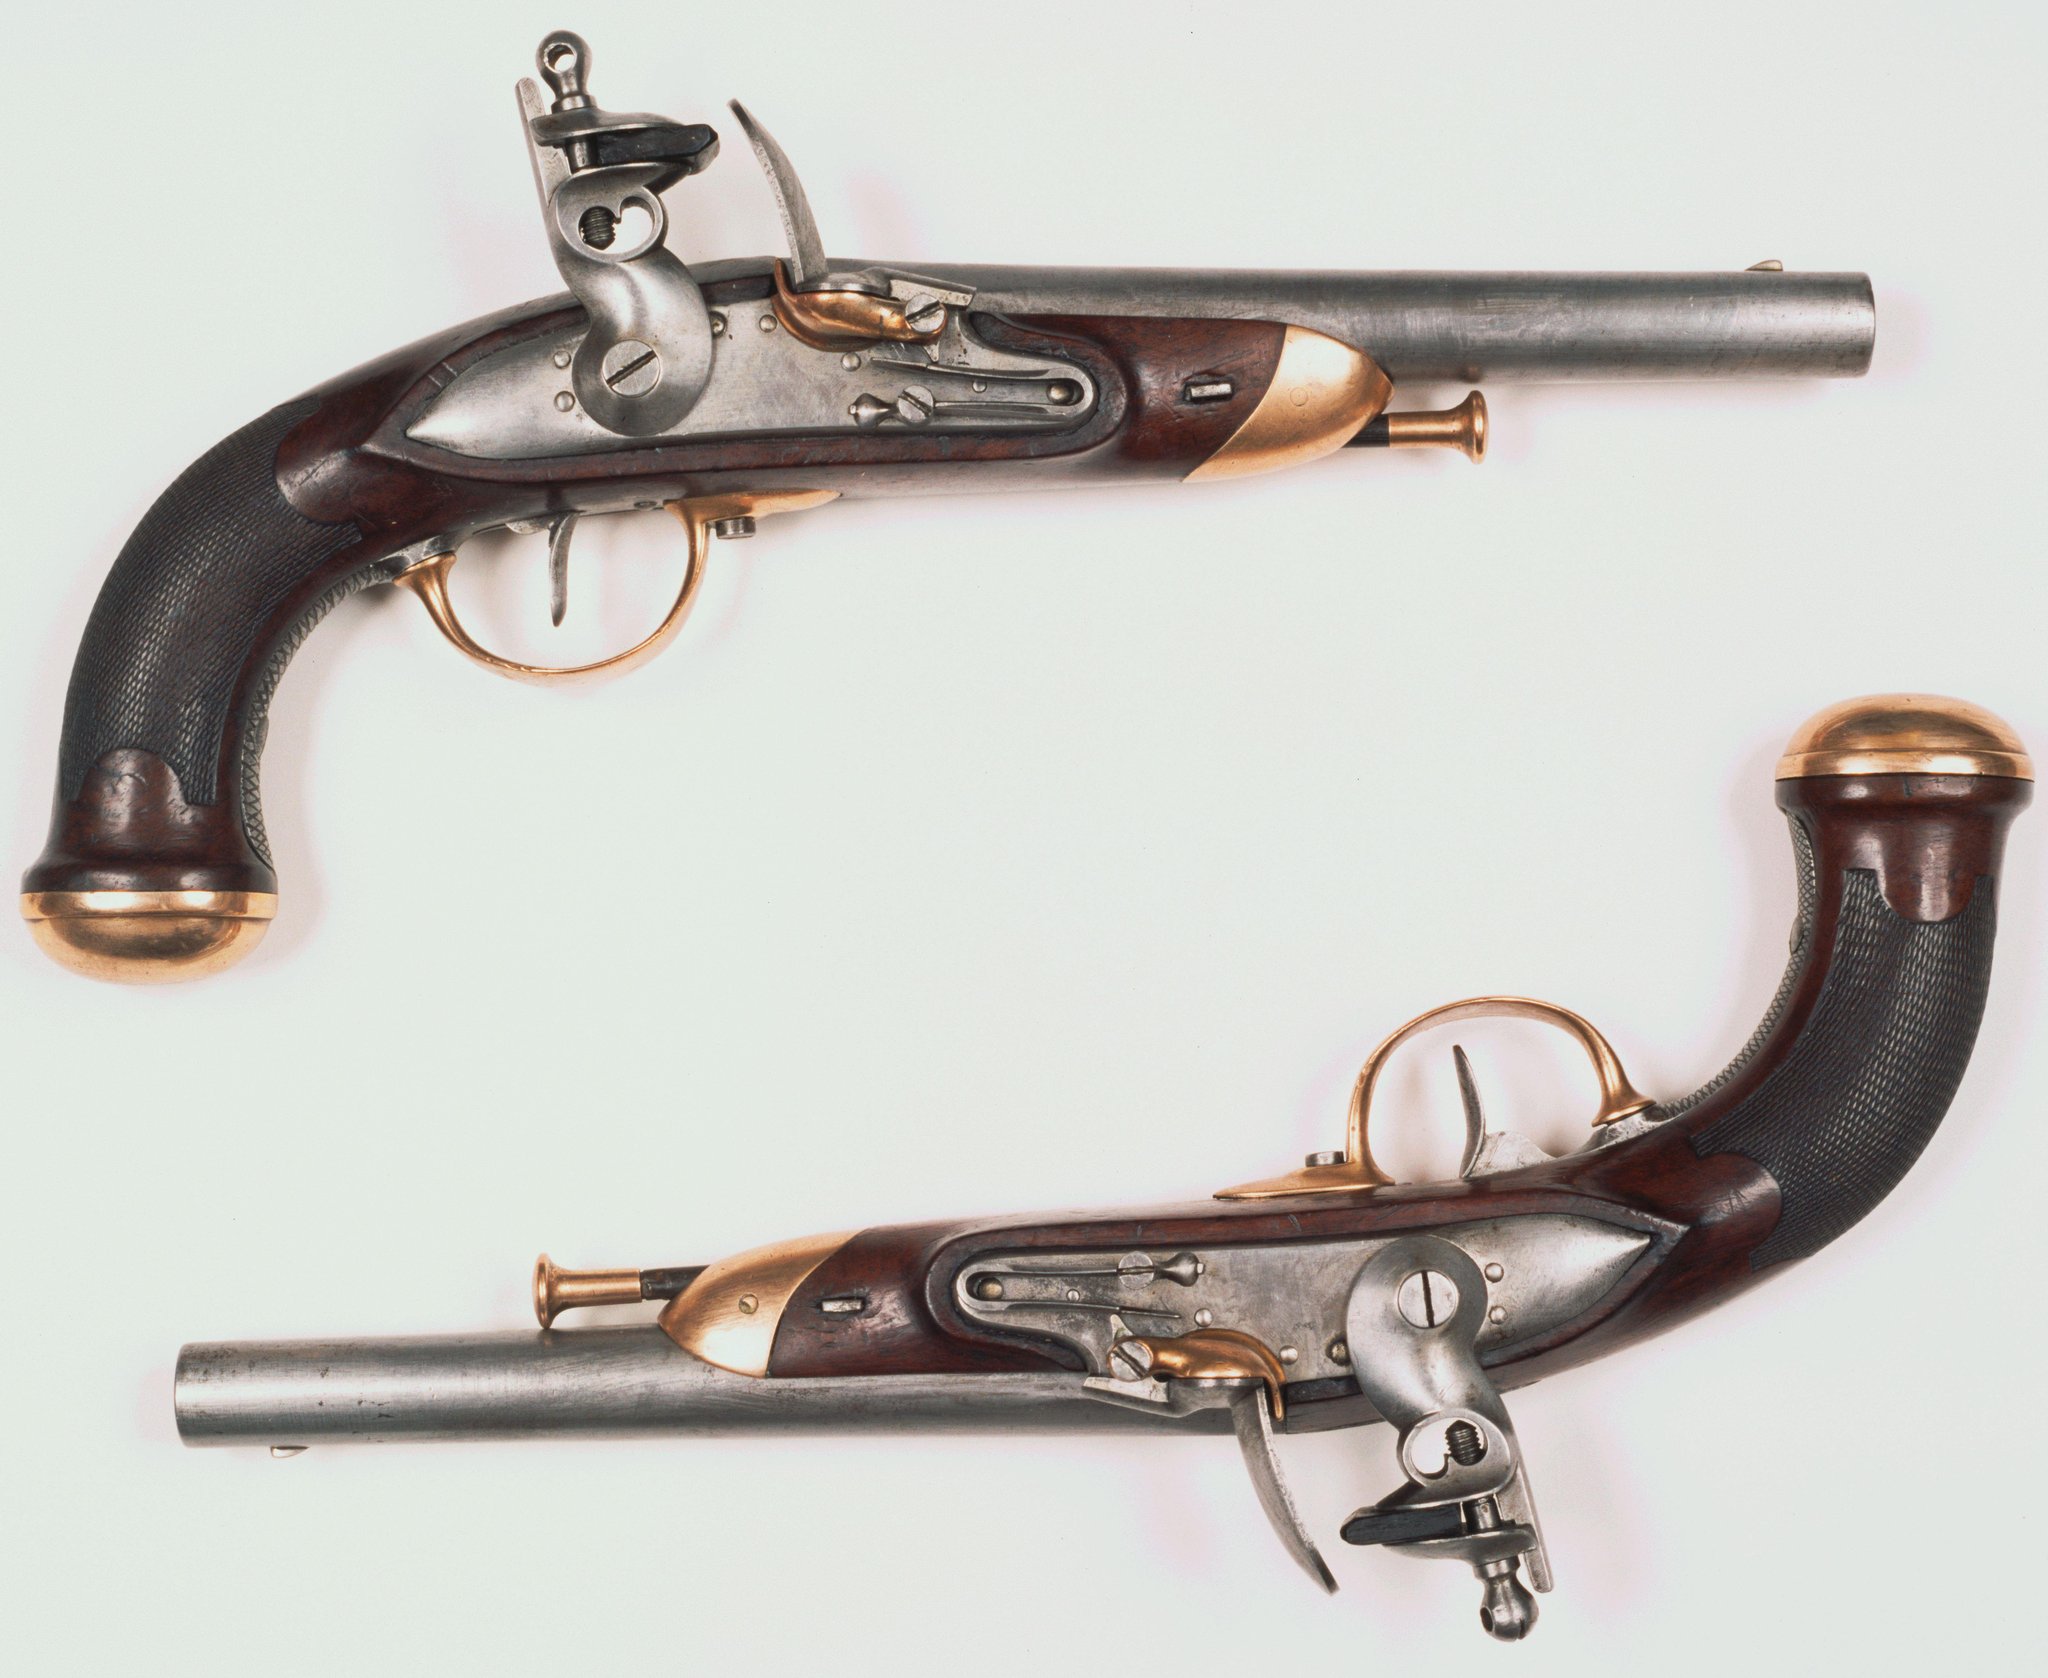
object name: flintlock pistol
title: Vuursteenpistool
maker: Anonymous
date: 1814-1866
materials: copper, alloy, iron, wood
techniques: cutting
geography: liège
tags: netherlands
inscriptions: mark: ‘E // L G // *’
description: Vuursteenpistool, deel van koppel, met gladde ronde loop met aan het uiteinde een kleine zilveren vizierkorrel, loop is gemerkt met 'ELG'. Houten lade met een koperen uiteinde, doorlopend in de kolf waarvan de greep geribbeld is en de kolfplaat van koper is. IJzeren slotplaat met koperen pan. Een houten laadstok met koperen kop bevindt zich in de lade. Koperen trekkerbeugel met ijzeren trekker.